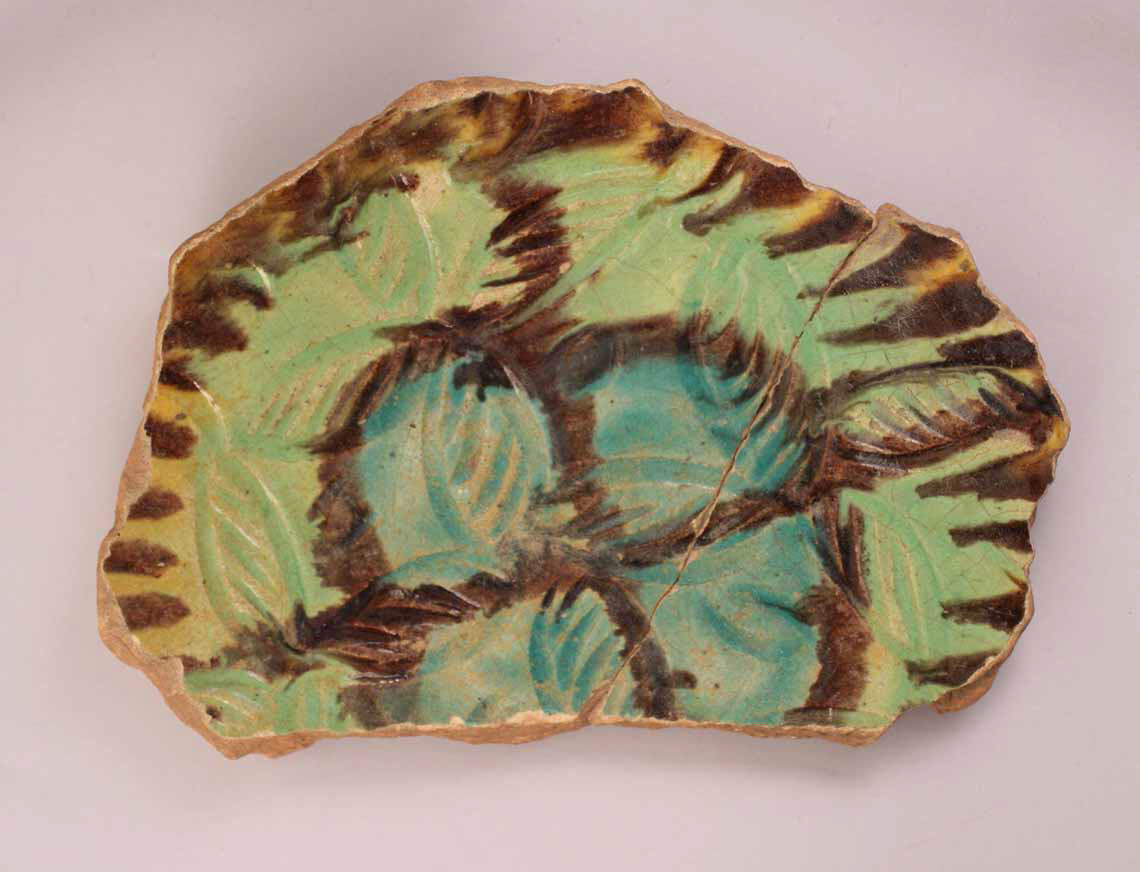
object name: ceramic fragment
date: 901-1200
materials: earthenware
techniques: glazing, molding, polychrome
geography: egypt